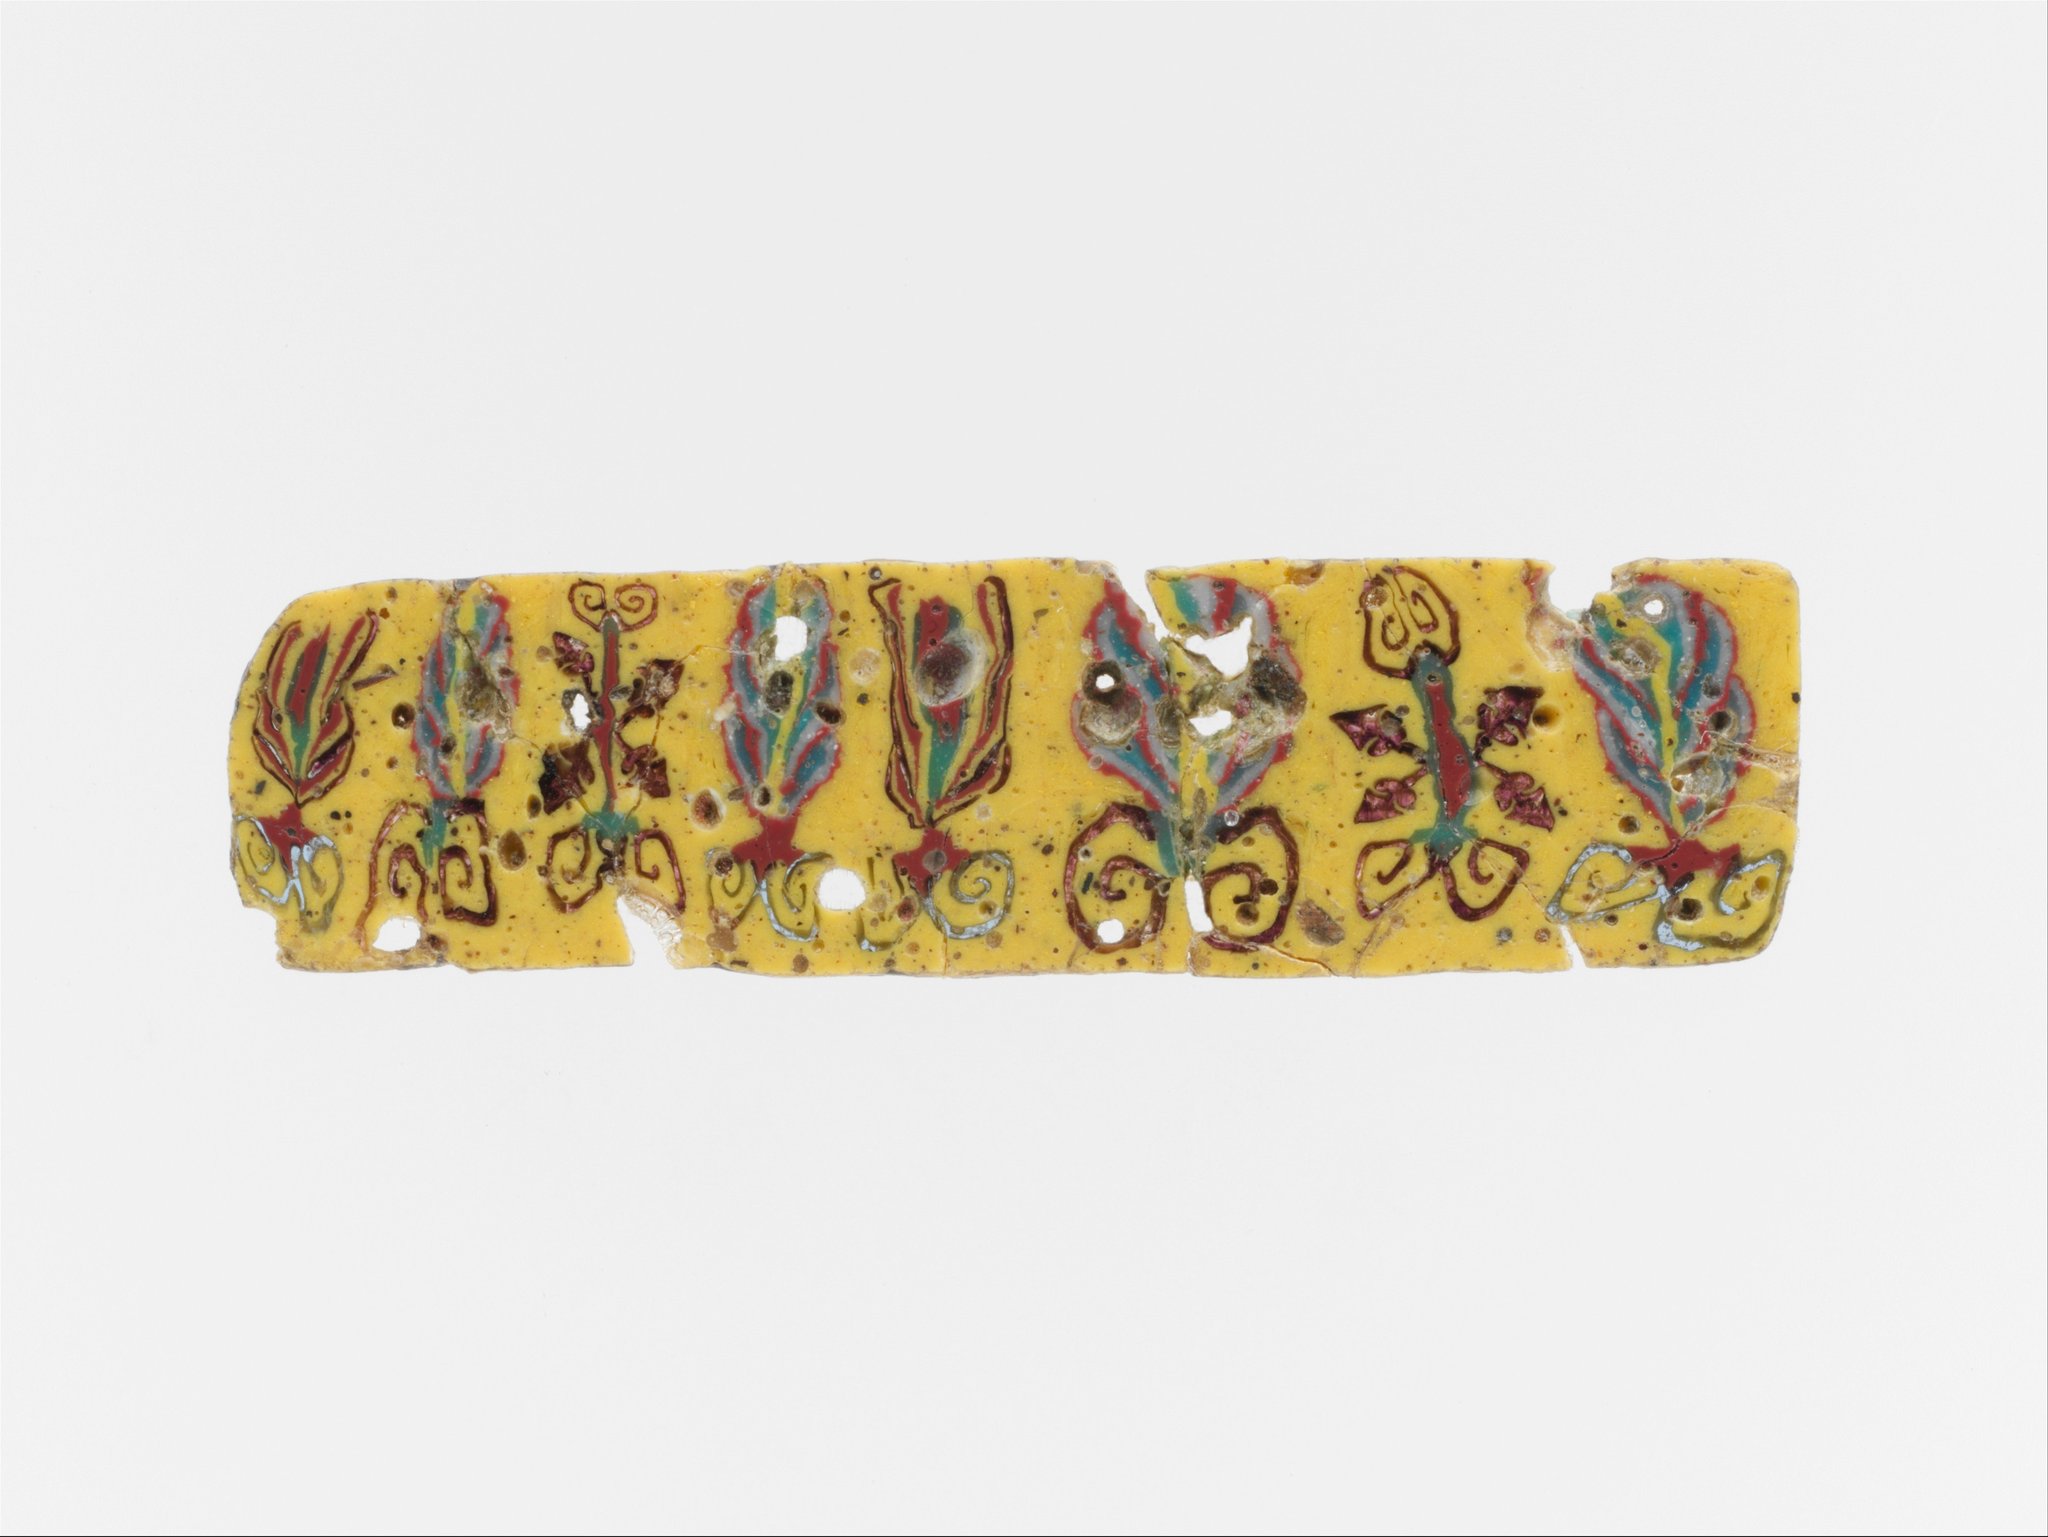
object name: mosaic block inlay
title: Glass mosaic inlay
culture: egyptian or roman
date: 100 BCE-100 CE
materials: glass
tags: palmettes,lotuses